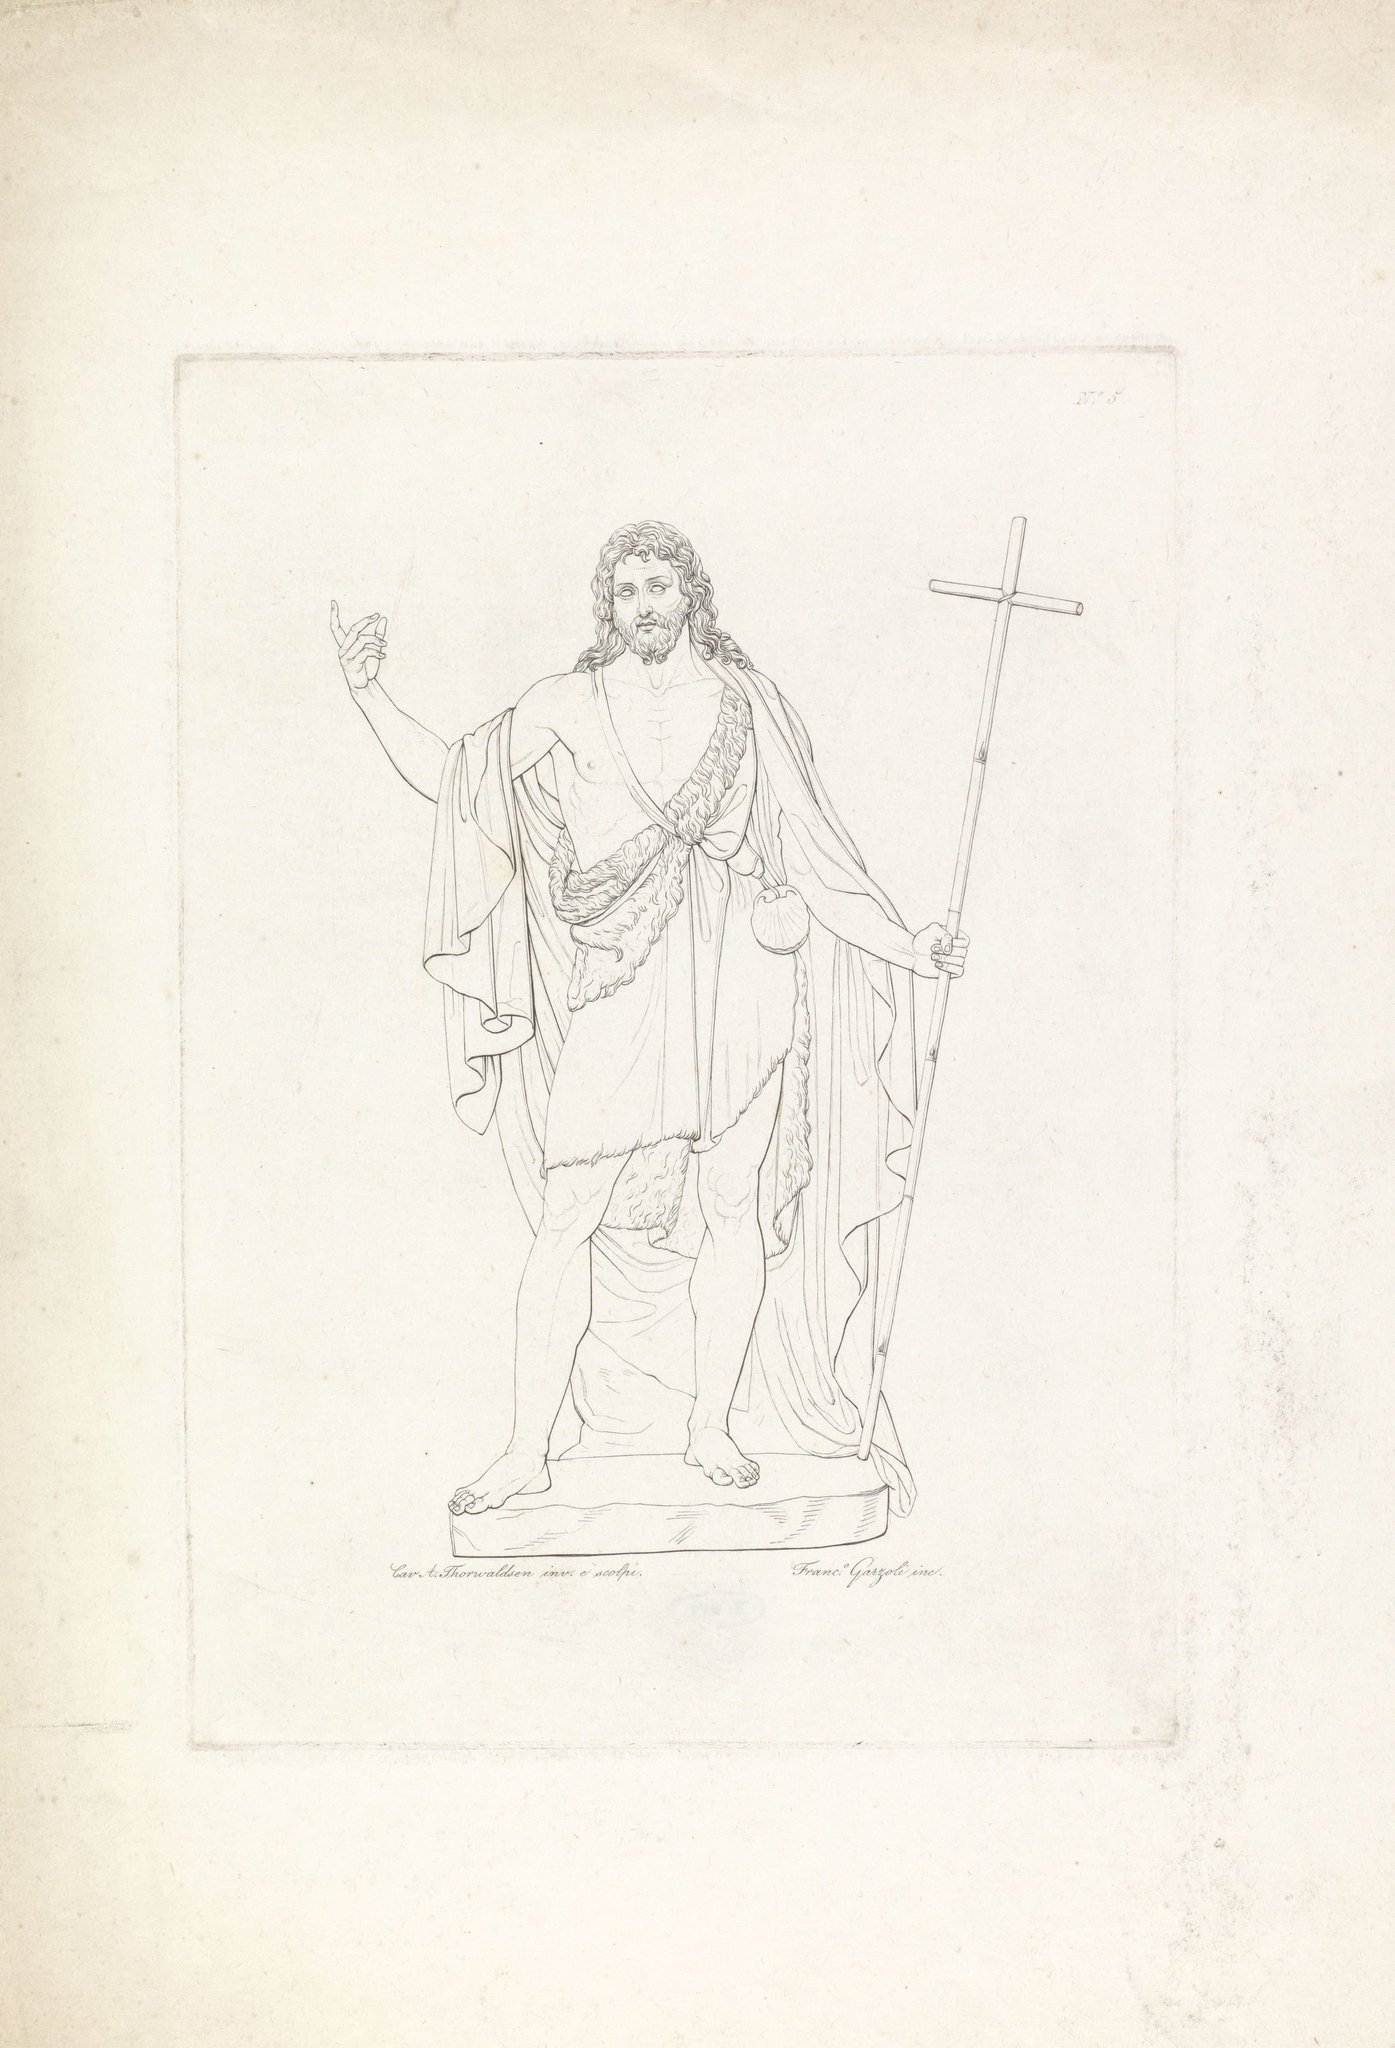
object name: print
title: Johannes de Doper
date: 1800-1899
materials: paper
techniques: etching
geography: copenhagen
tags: series of scenes from the life of john the baptist, piece of sculpture, reproduction of a piece of sculpture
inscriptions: collector's mark: Lugt 2228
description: Een sculptuur van Johannes de Doper door Bertel Thorvaldsen. Genummerd rechtsboven: No. 5.